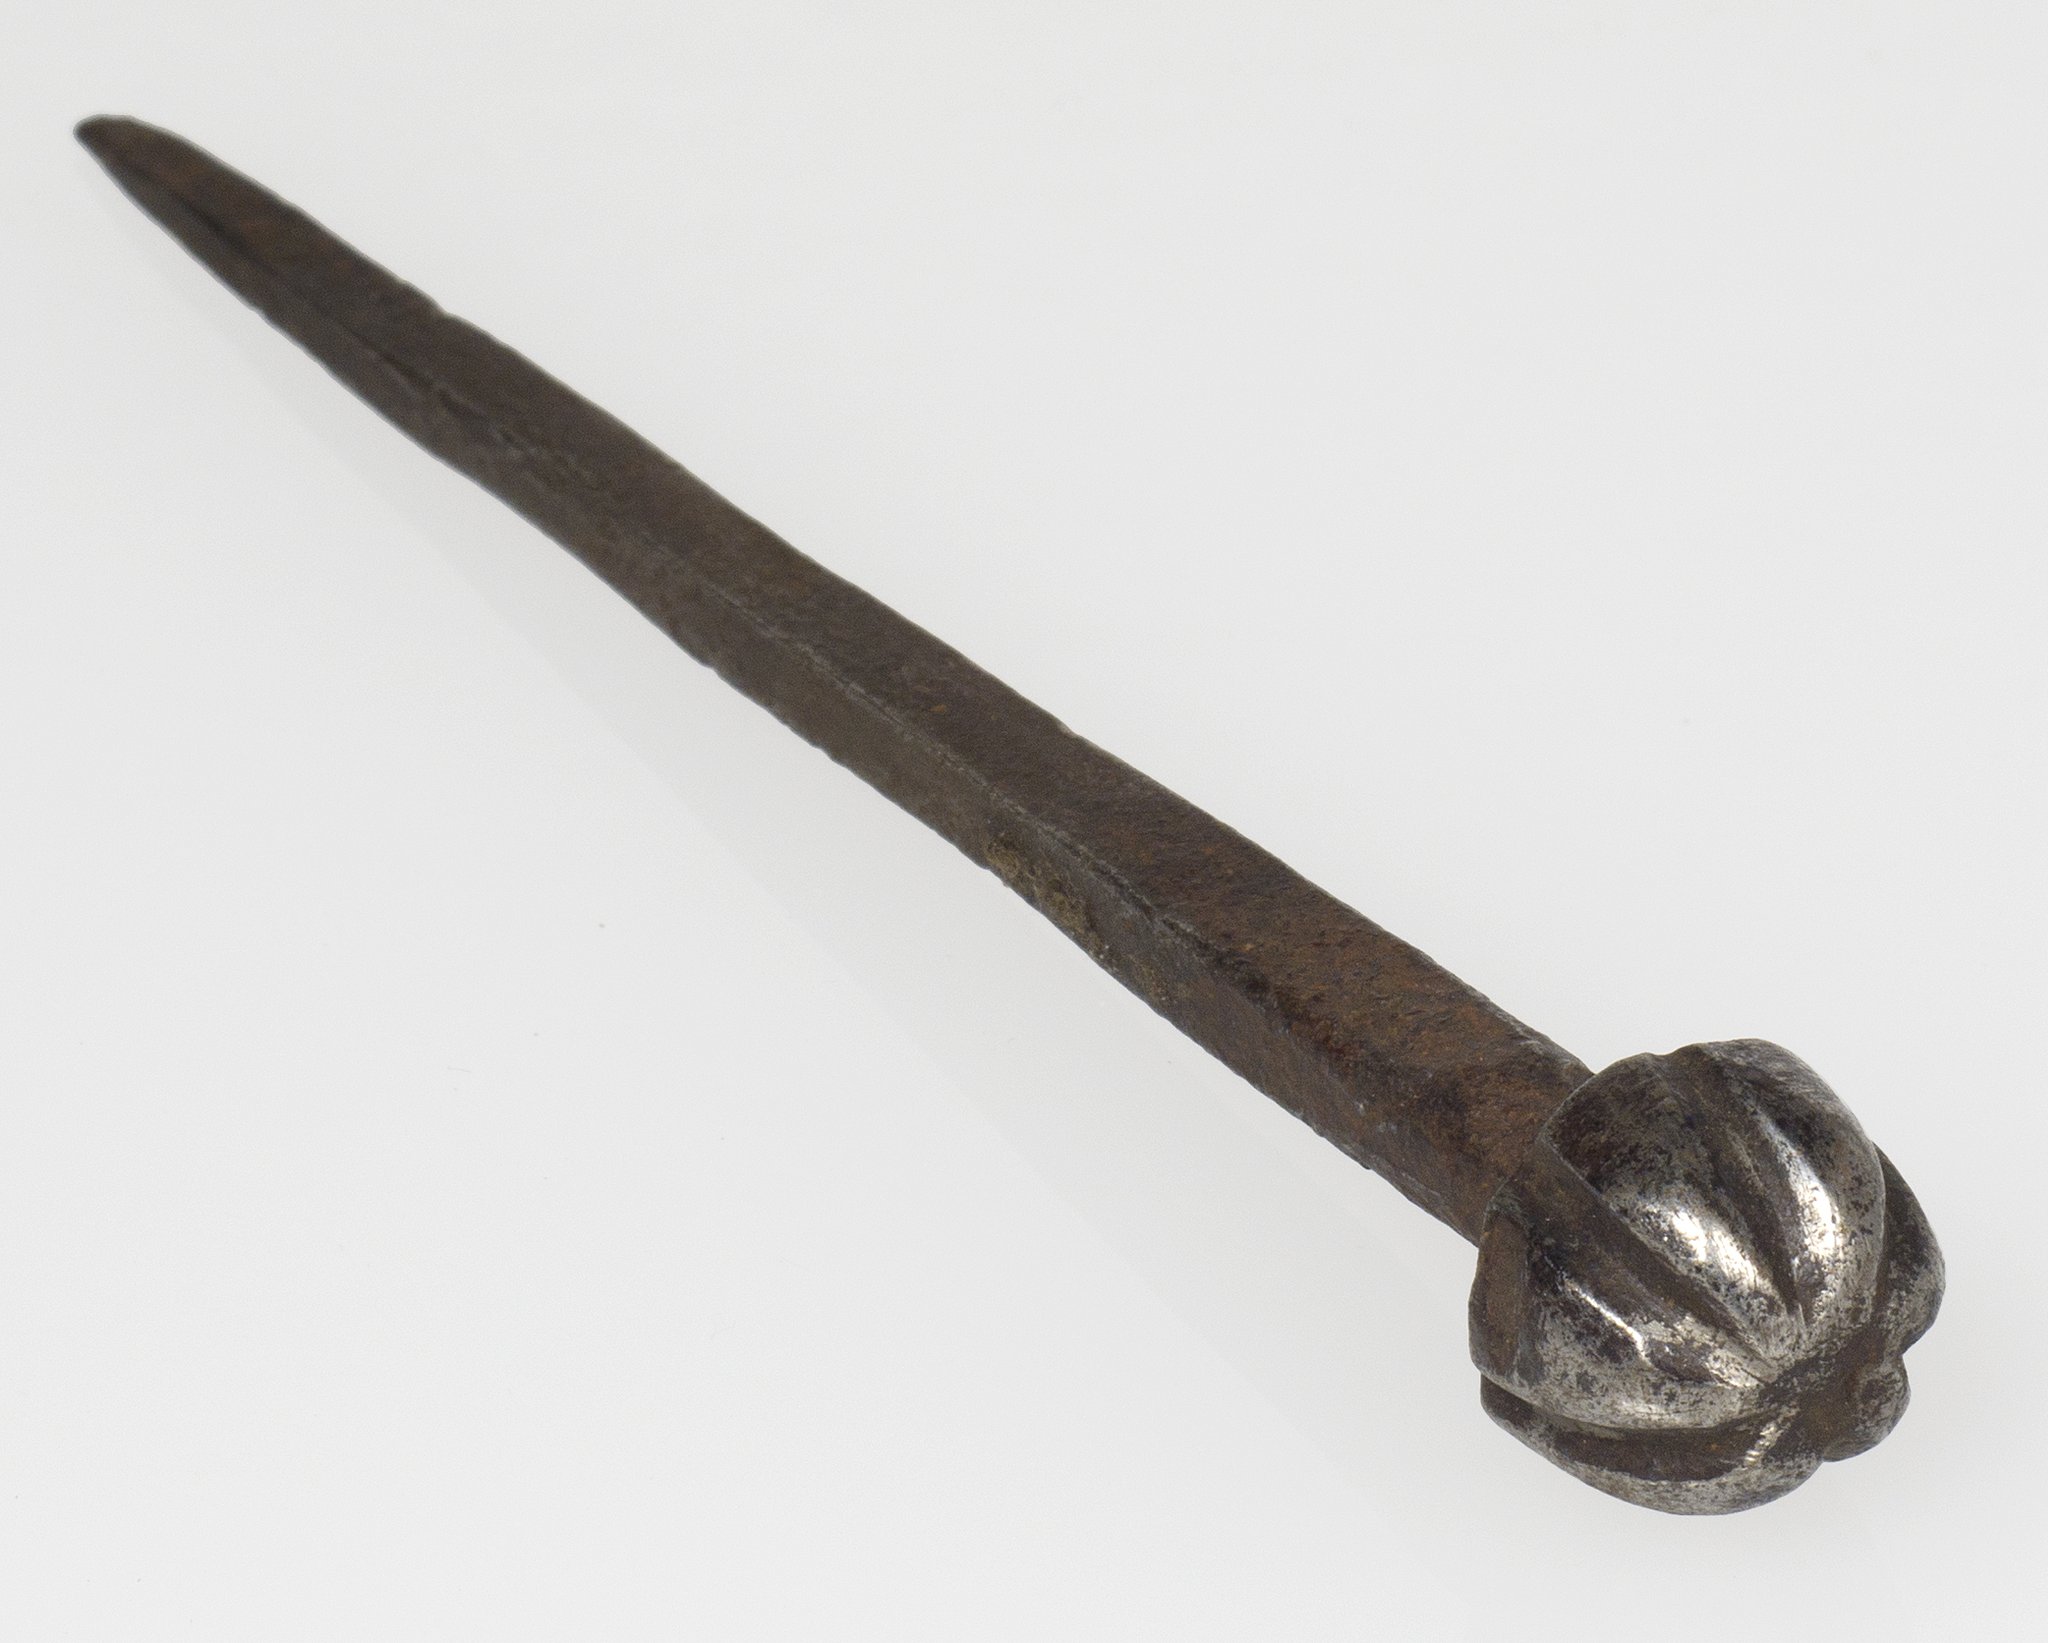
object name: nail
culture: european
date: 1401-1600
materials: iron